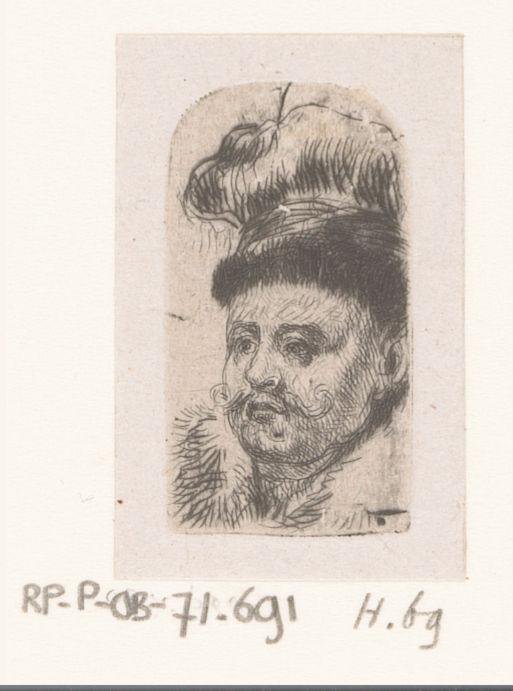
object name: print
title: Kop van man met hoed en bontkraag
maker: jean pierre norblin de la gourdaine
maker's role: print maker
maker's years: 1745-1830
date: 1755-1830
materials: paper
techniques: etching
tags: head-gear: hat